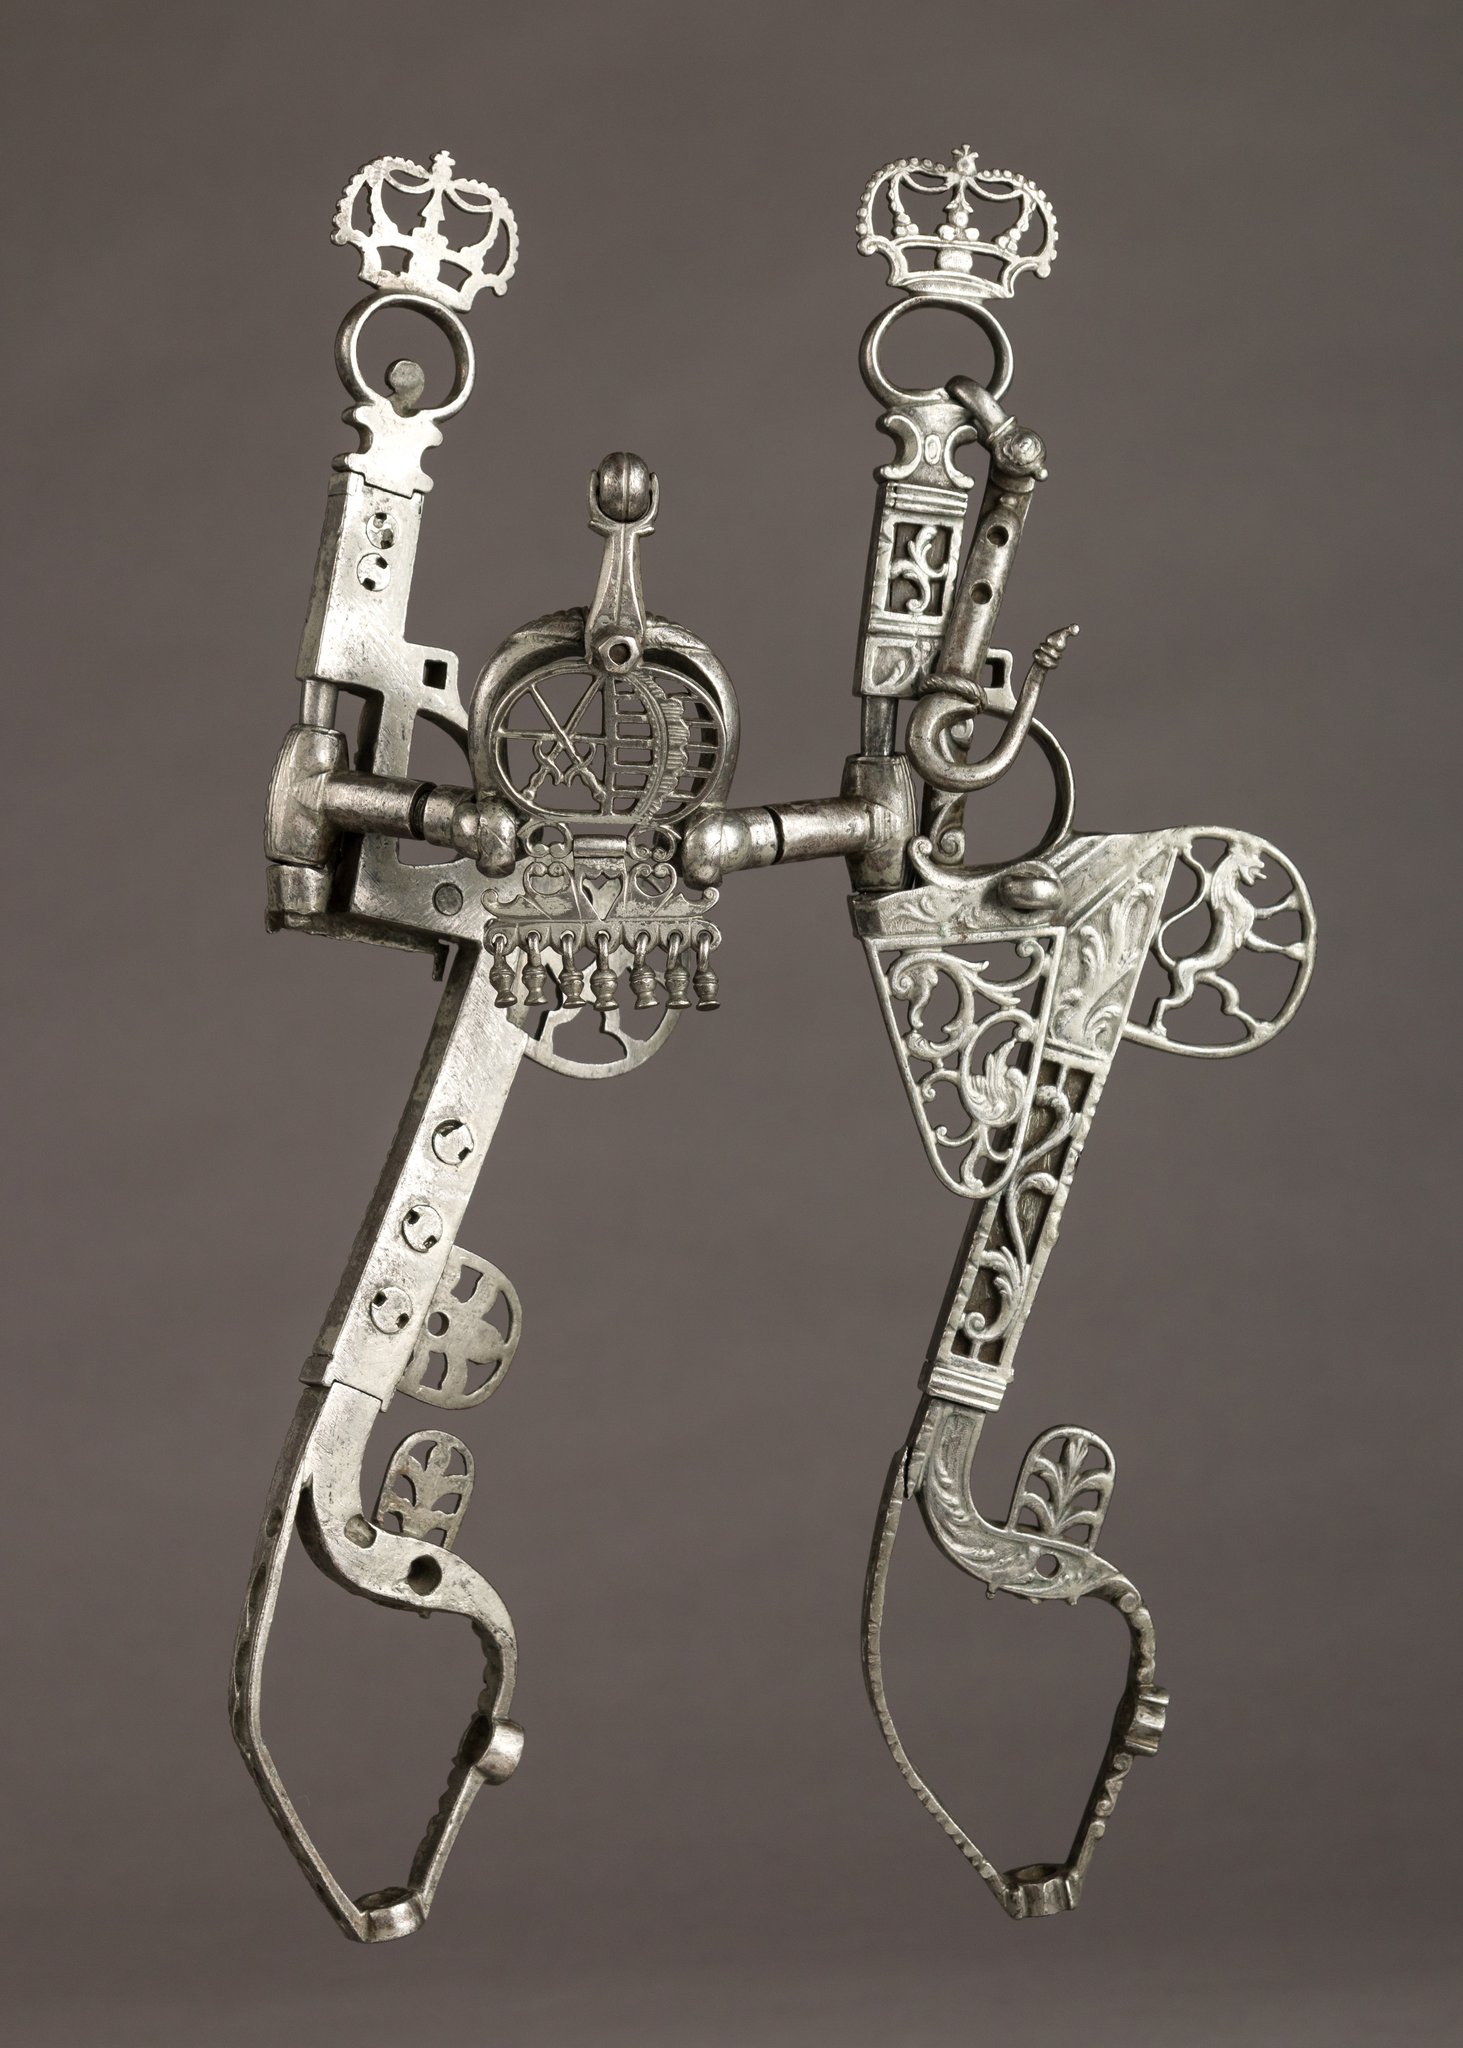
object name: bit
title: Curb Bit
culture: german, saxony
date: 1601-1633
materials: metal alloy, tin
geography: germany